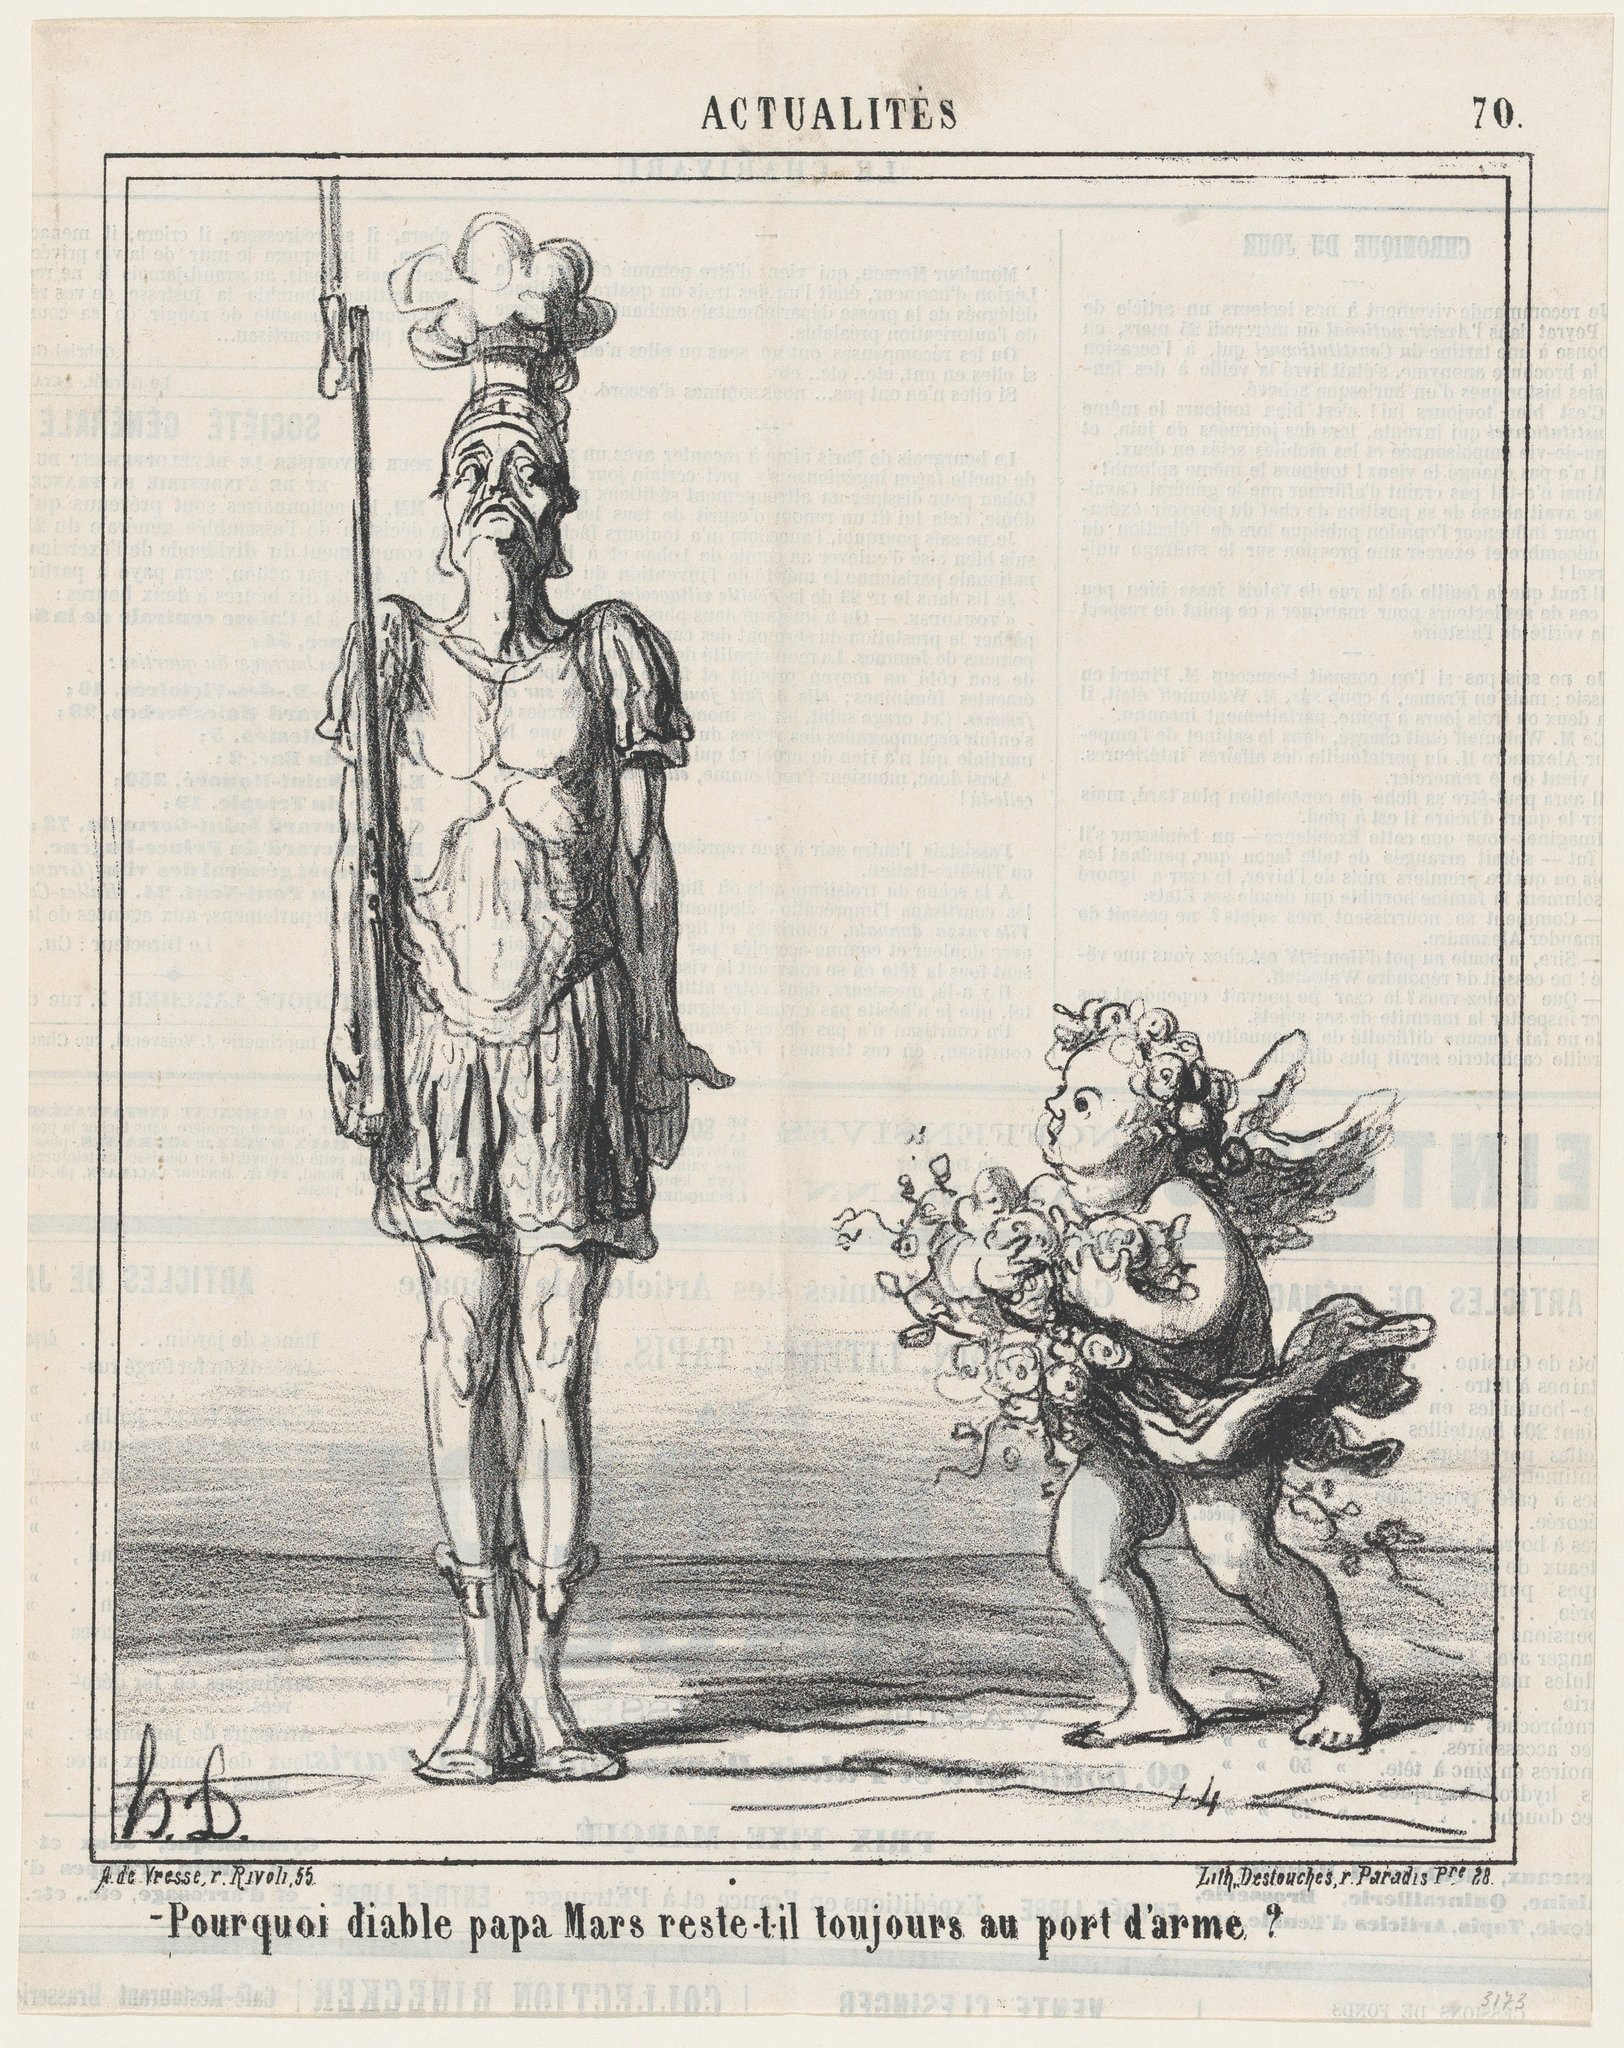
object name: print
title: Why the hell does Mars still have a weapon?, from 'News of the day,' published in "Le Charivari"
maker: honoré daumier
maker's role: artist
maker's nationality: french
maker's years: 1808-1879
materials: paper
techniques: lithograph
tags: weapons,mars